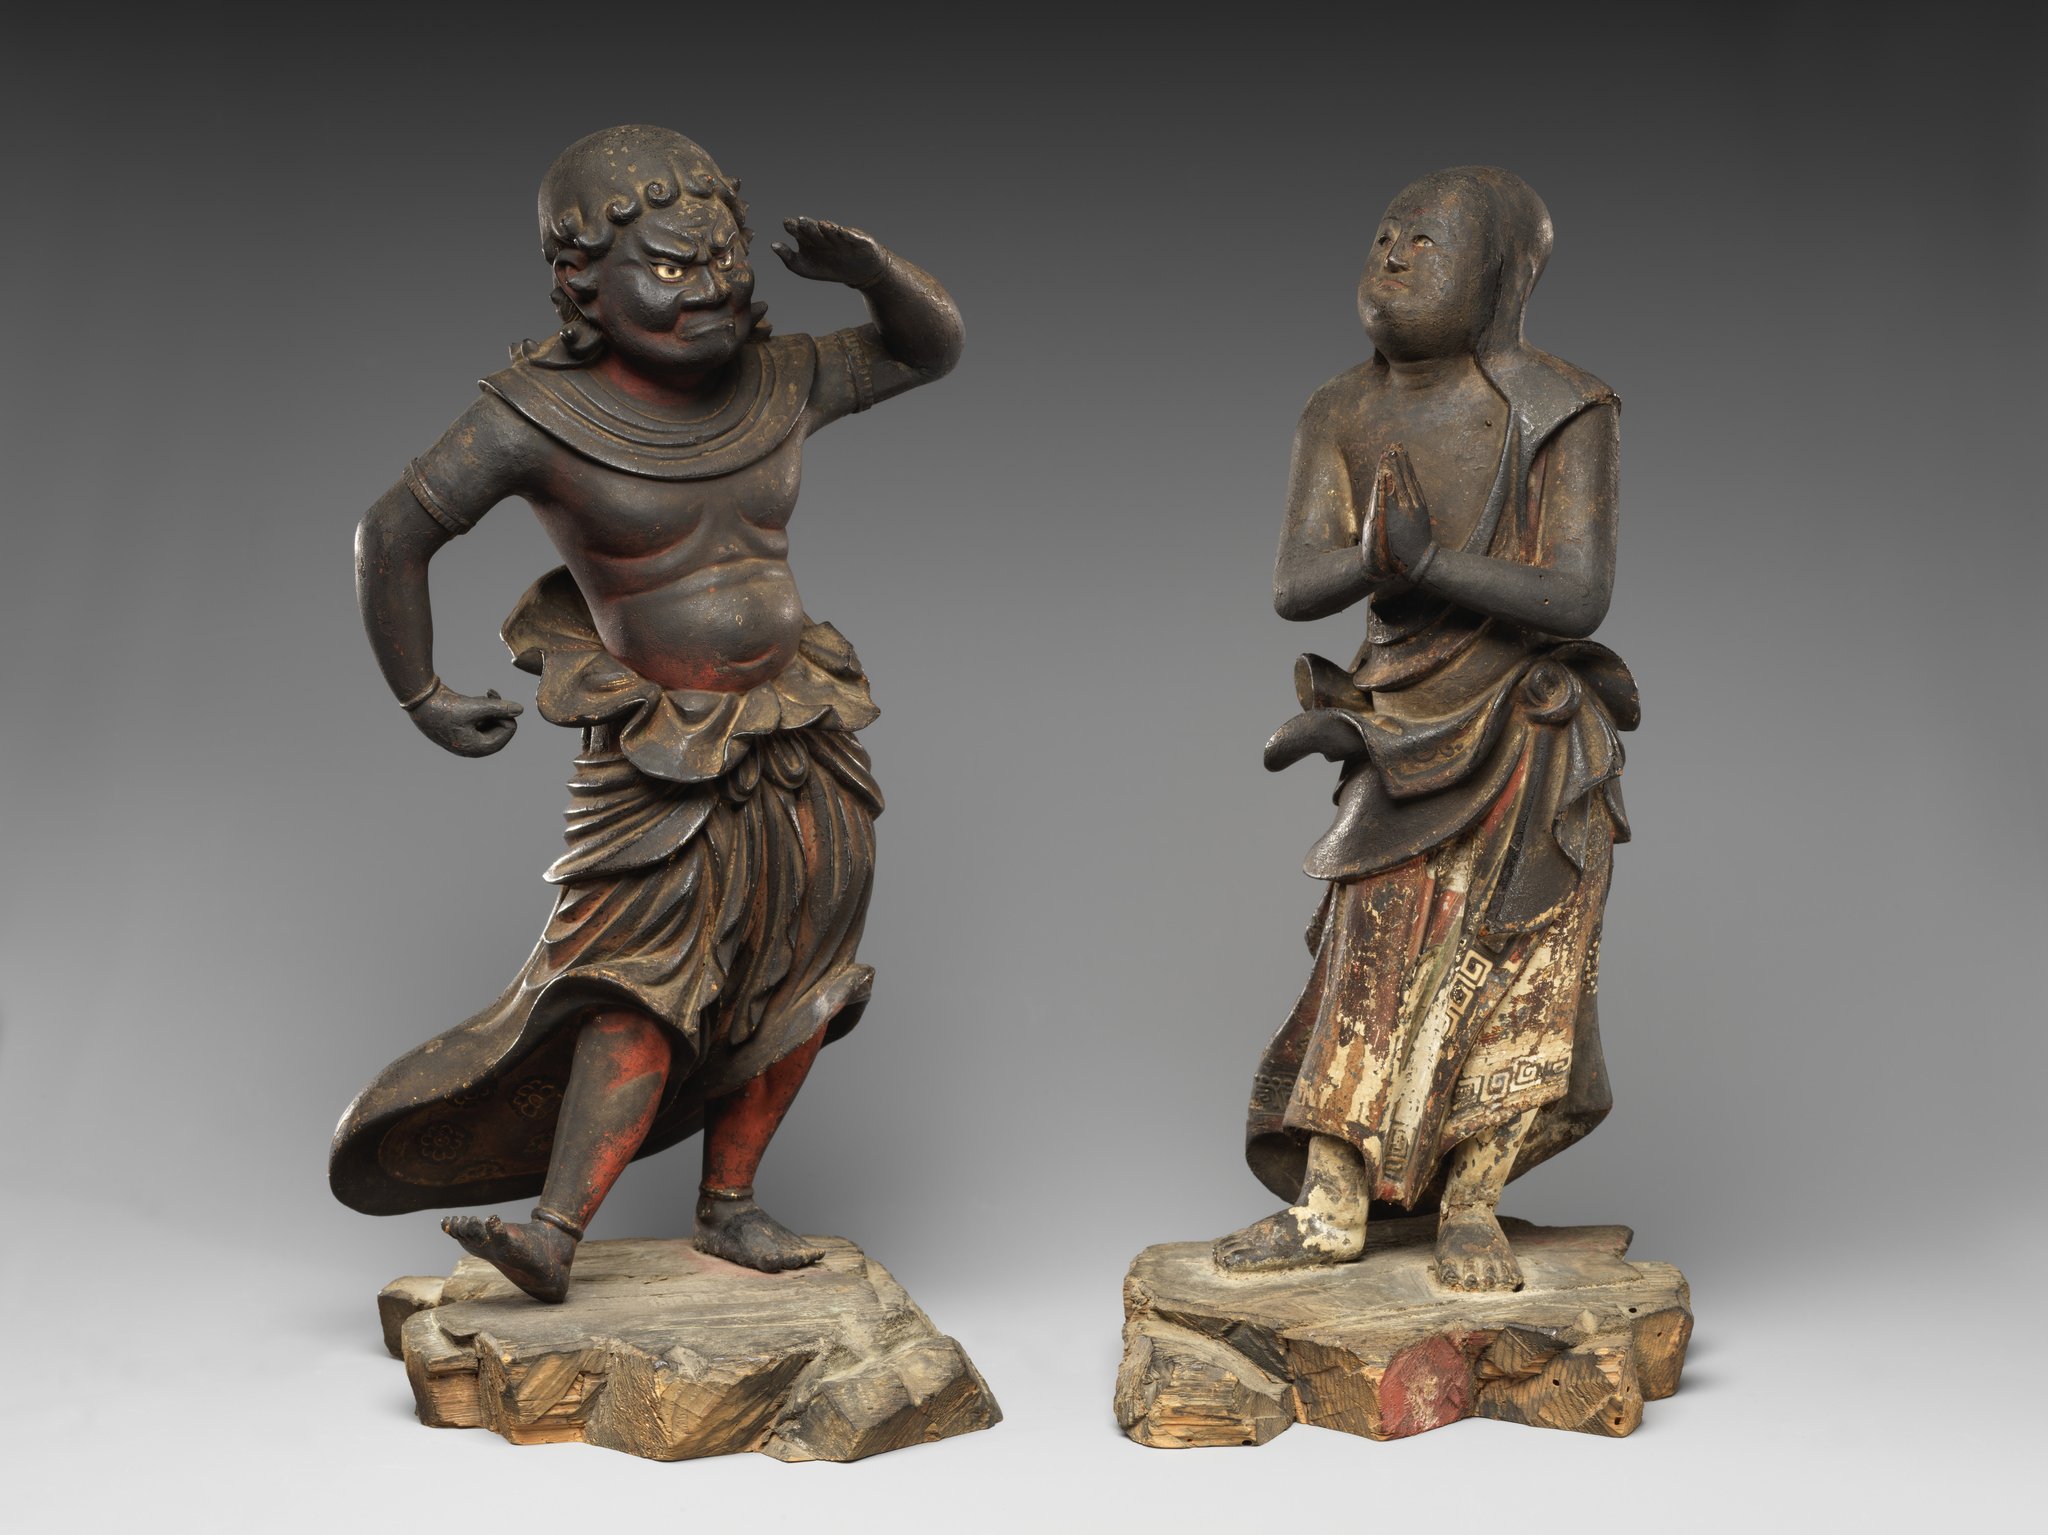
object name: pair of sculpture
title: The Boy Attendants Kongara Dōji and Seitaka Dōji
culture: japanese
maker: unidentified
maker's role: artist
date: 1350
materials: glass, paint, wood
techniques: inlay, lacquer